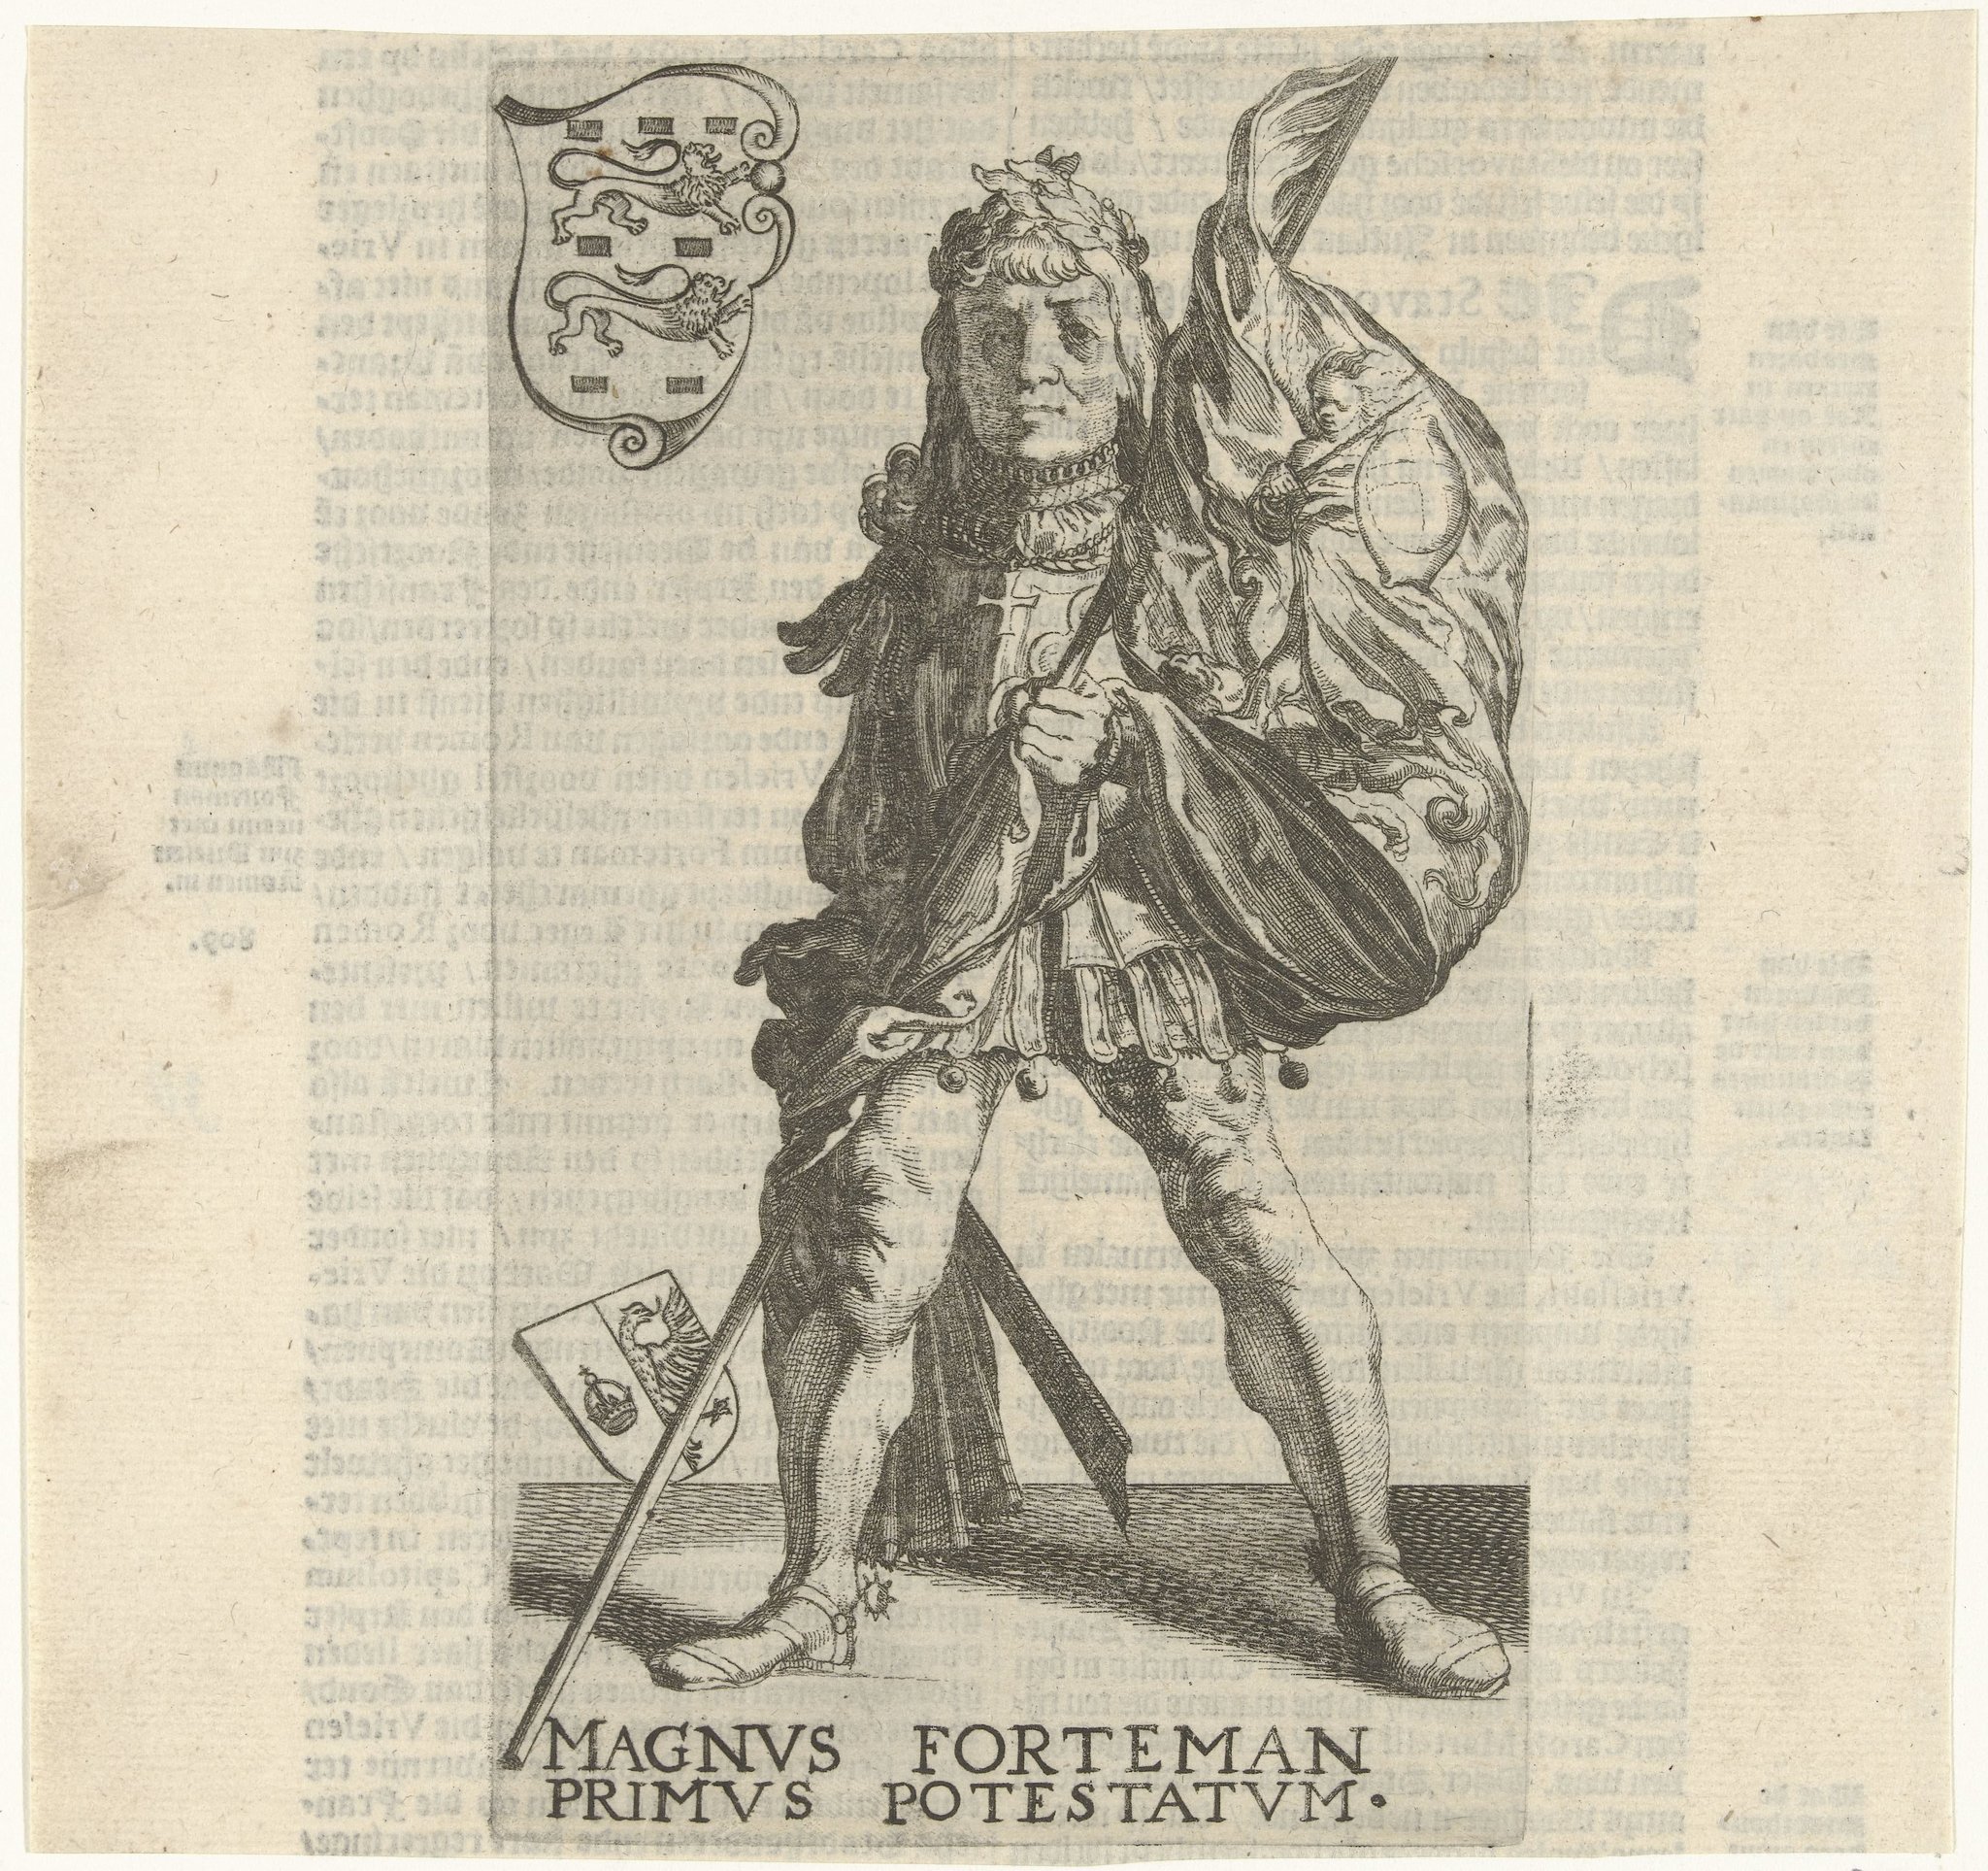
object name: print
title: Magnvs Forteman primvs potestatvm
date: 1622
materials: paper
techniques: etching, letterpress printing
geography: northern netherlands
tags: magnus forteman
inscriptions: collector's mark: Lugt 2228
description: De prent is ook als boekillustratie gebruikt in: Winsemius, P.W. Chronique ofte Historische geschiedenisse van Vrieslant (...). Franeker: Joannes Lamrinck, 1622.